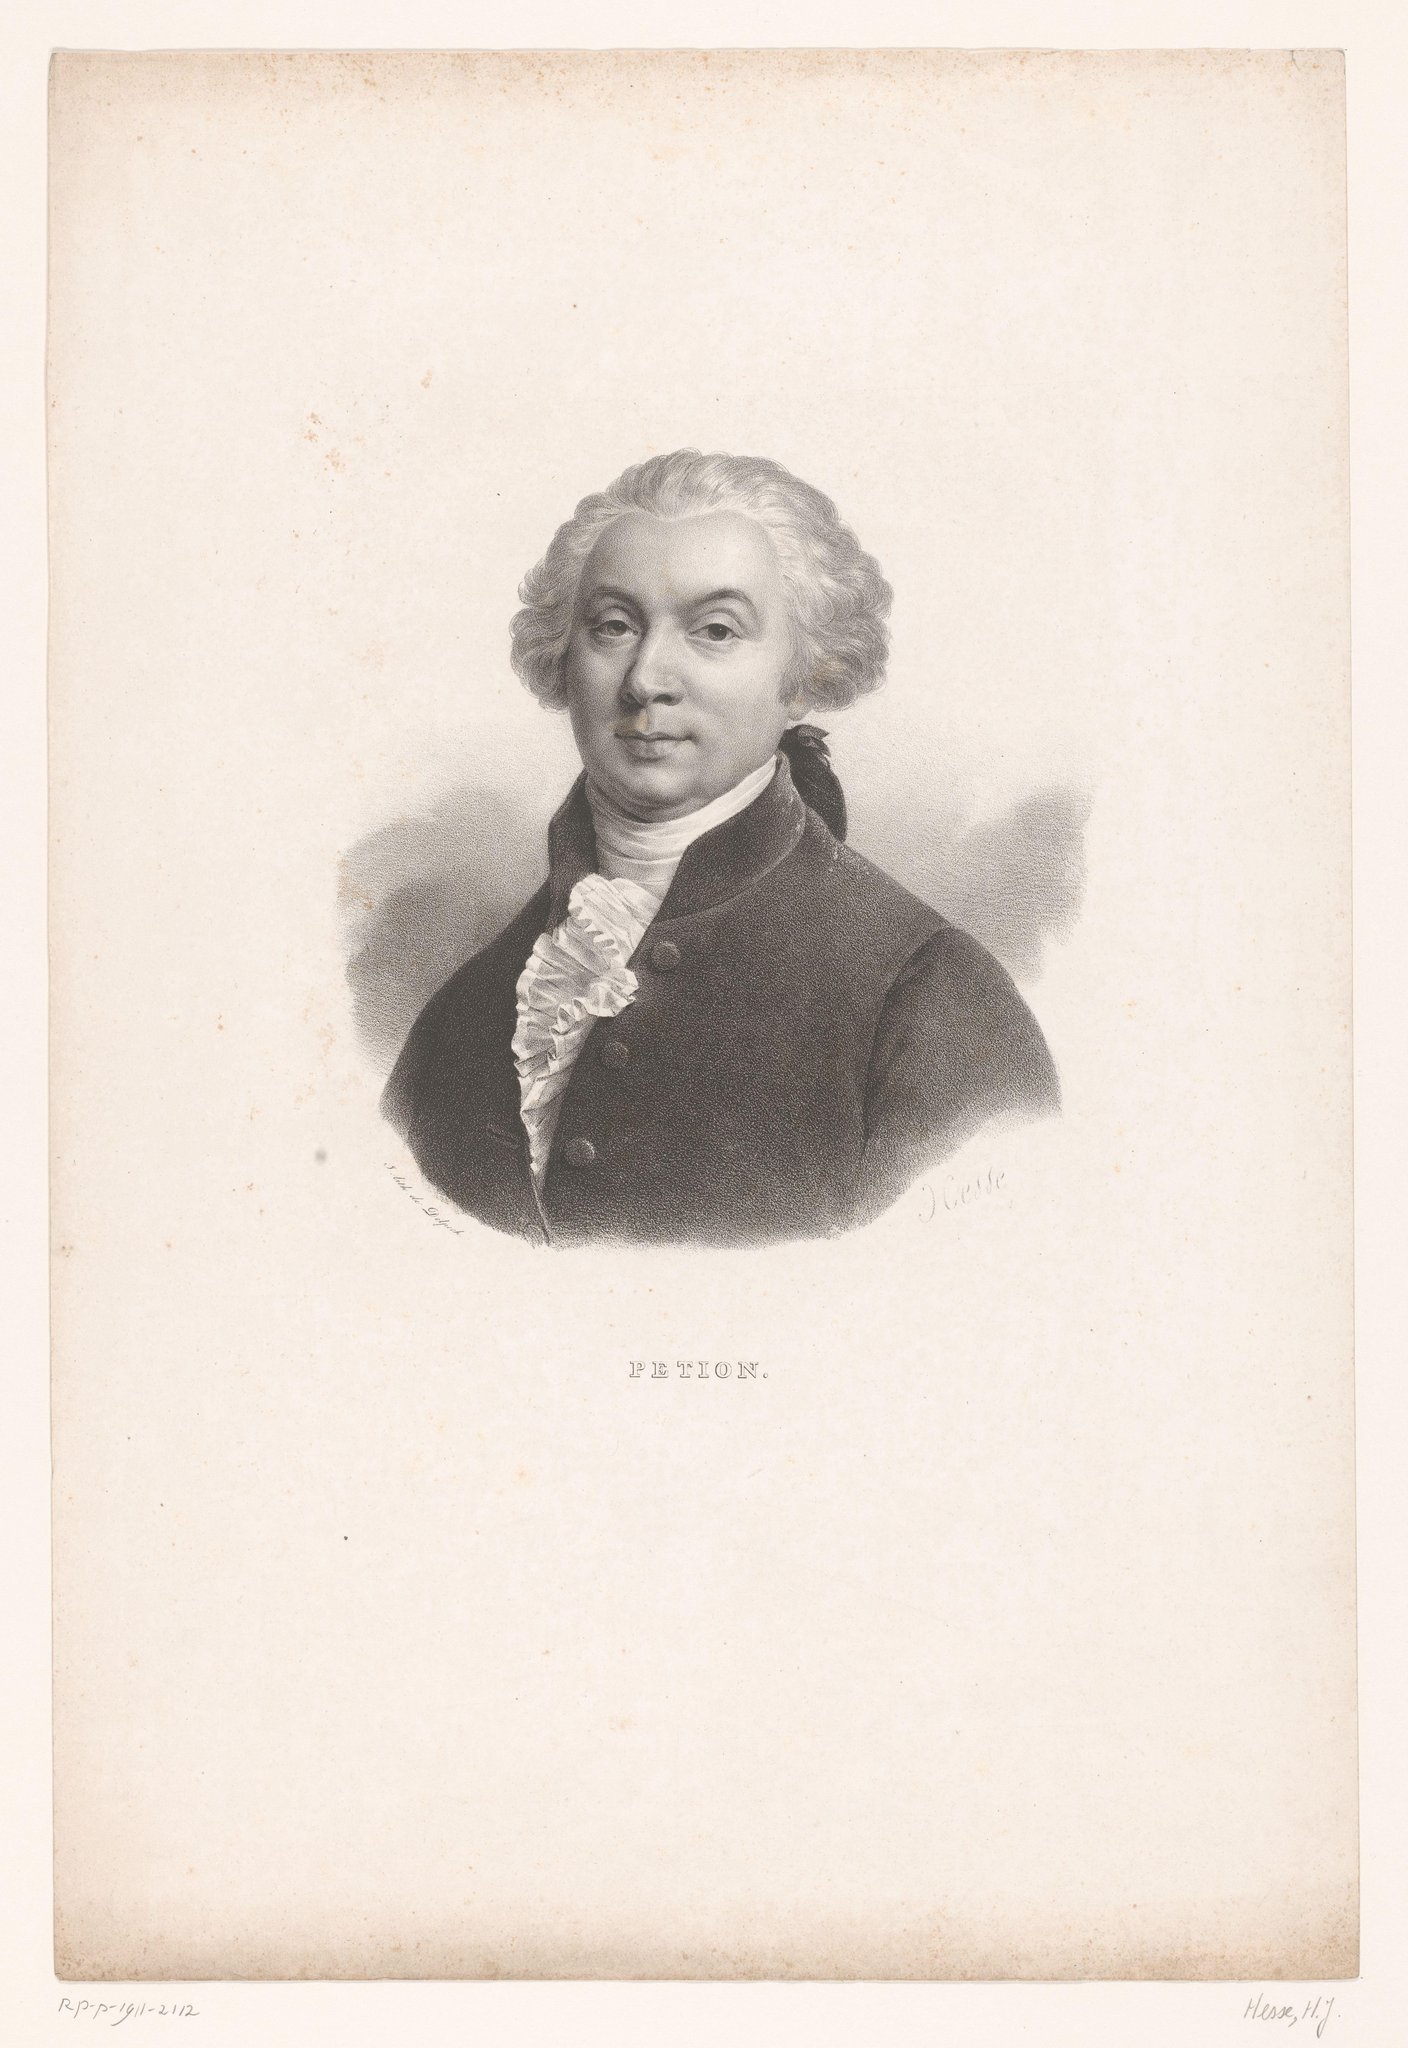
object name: print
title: Portret van Jérôme Pétion de Villeneuve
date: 1823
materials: paper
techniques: lithograph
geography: paris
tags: politician, historical persons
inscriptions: collector's mark: Lugt 2228a